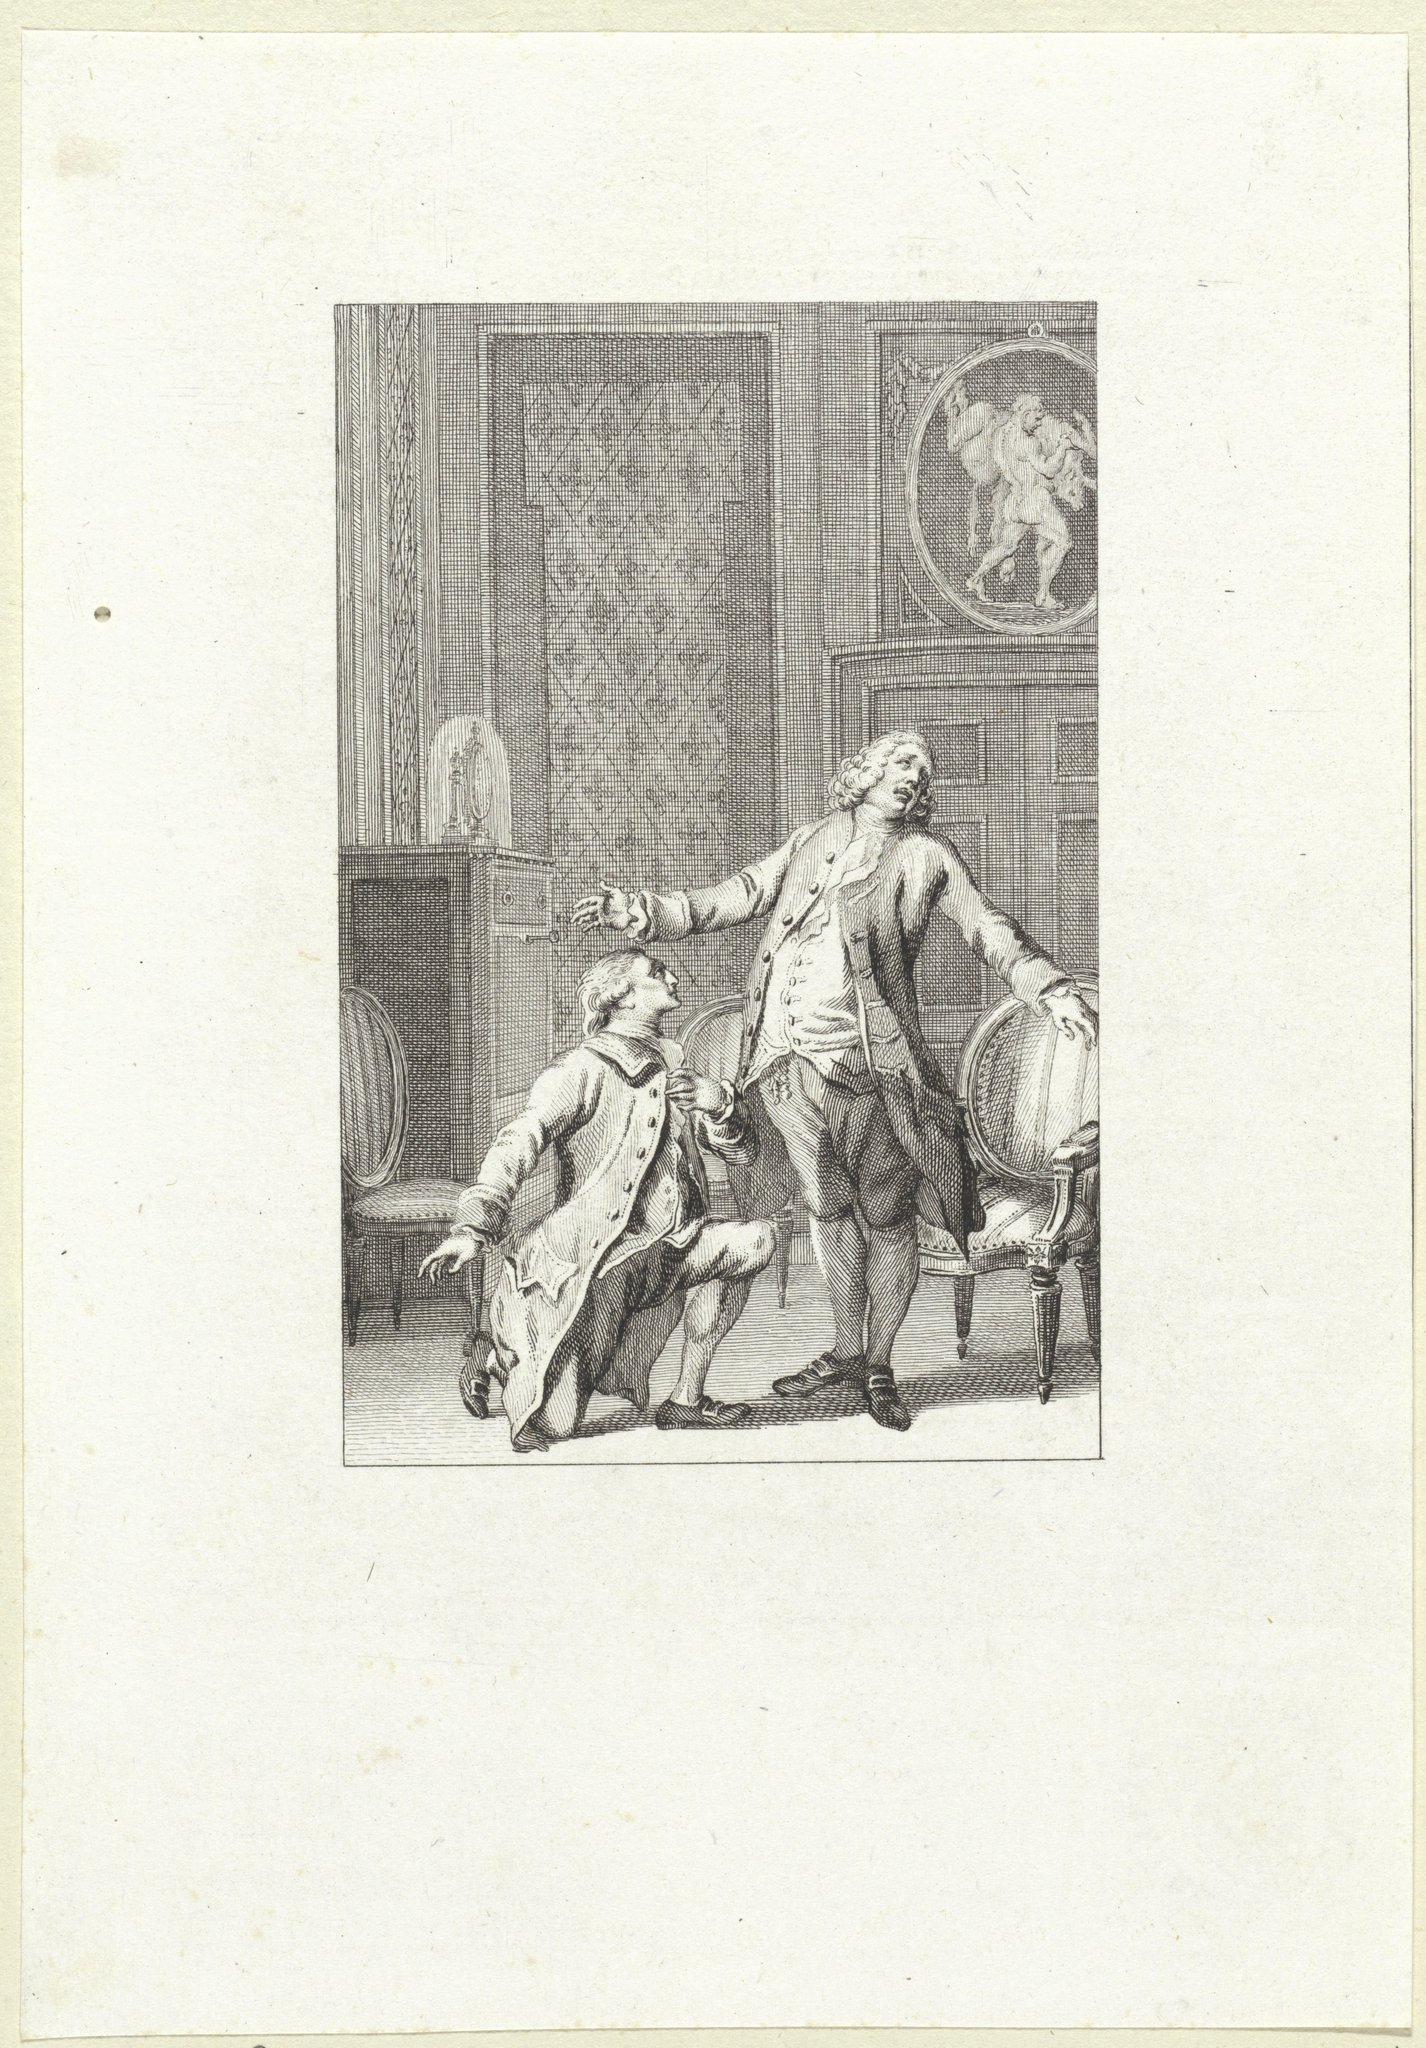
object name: print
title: Heer knielt voor De Franval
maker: reinier vinkeles (i)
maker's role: draughtsman, print maker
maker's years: 1741-1816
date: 1786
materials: paper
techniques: engraving, etching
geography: amsterdam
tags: kneeling figure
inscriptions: collector's mark: Lugt 240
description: Proefdruk van illustratie voor het toneelstuk: Desormes en Klementina, 1786.